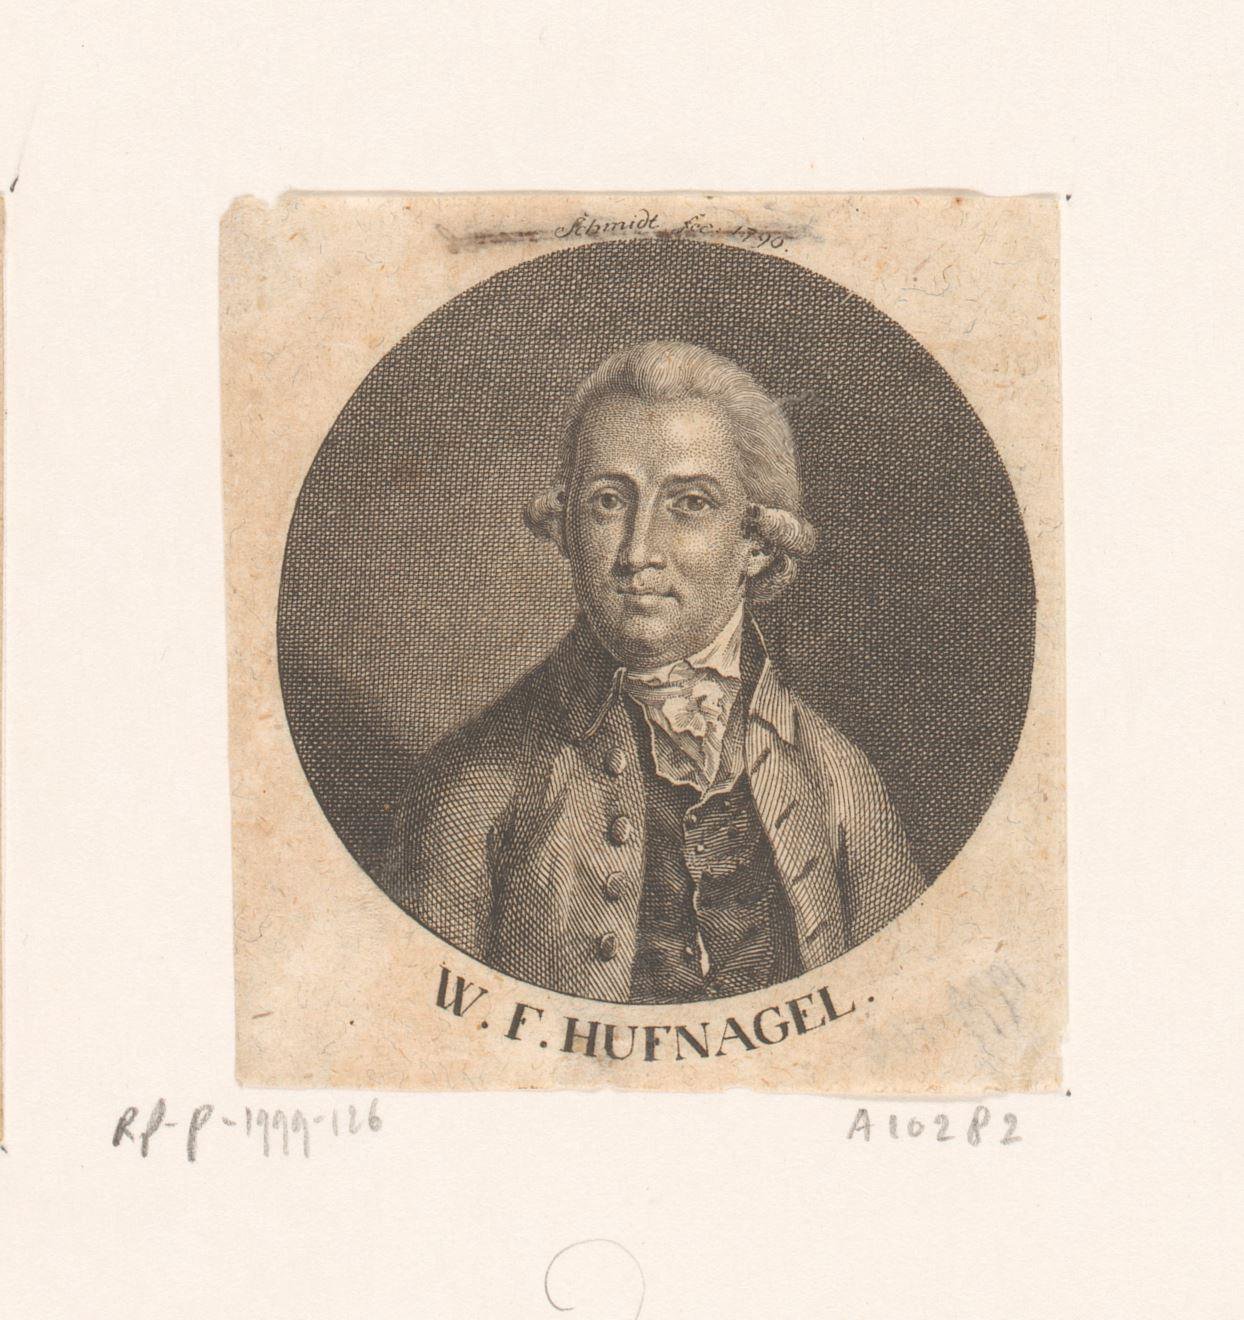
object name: print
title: Portret van Wilhelm Friedrich Hufnagel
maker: georg christoph schmidt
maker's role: print maker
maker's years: 1740-1811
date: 1790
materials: paper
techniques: engraving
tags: historical persons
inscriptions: collector's mark: Lugt 2760, collector's mark: Lugt 2228